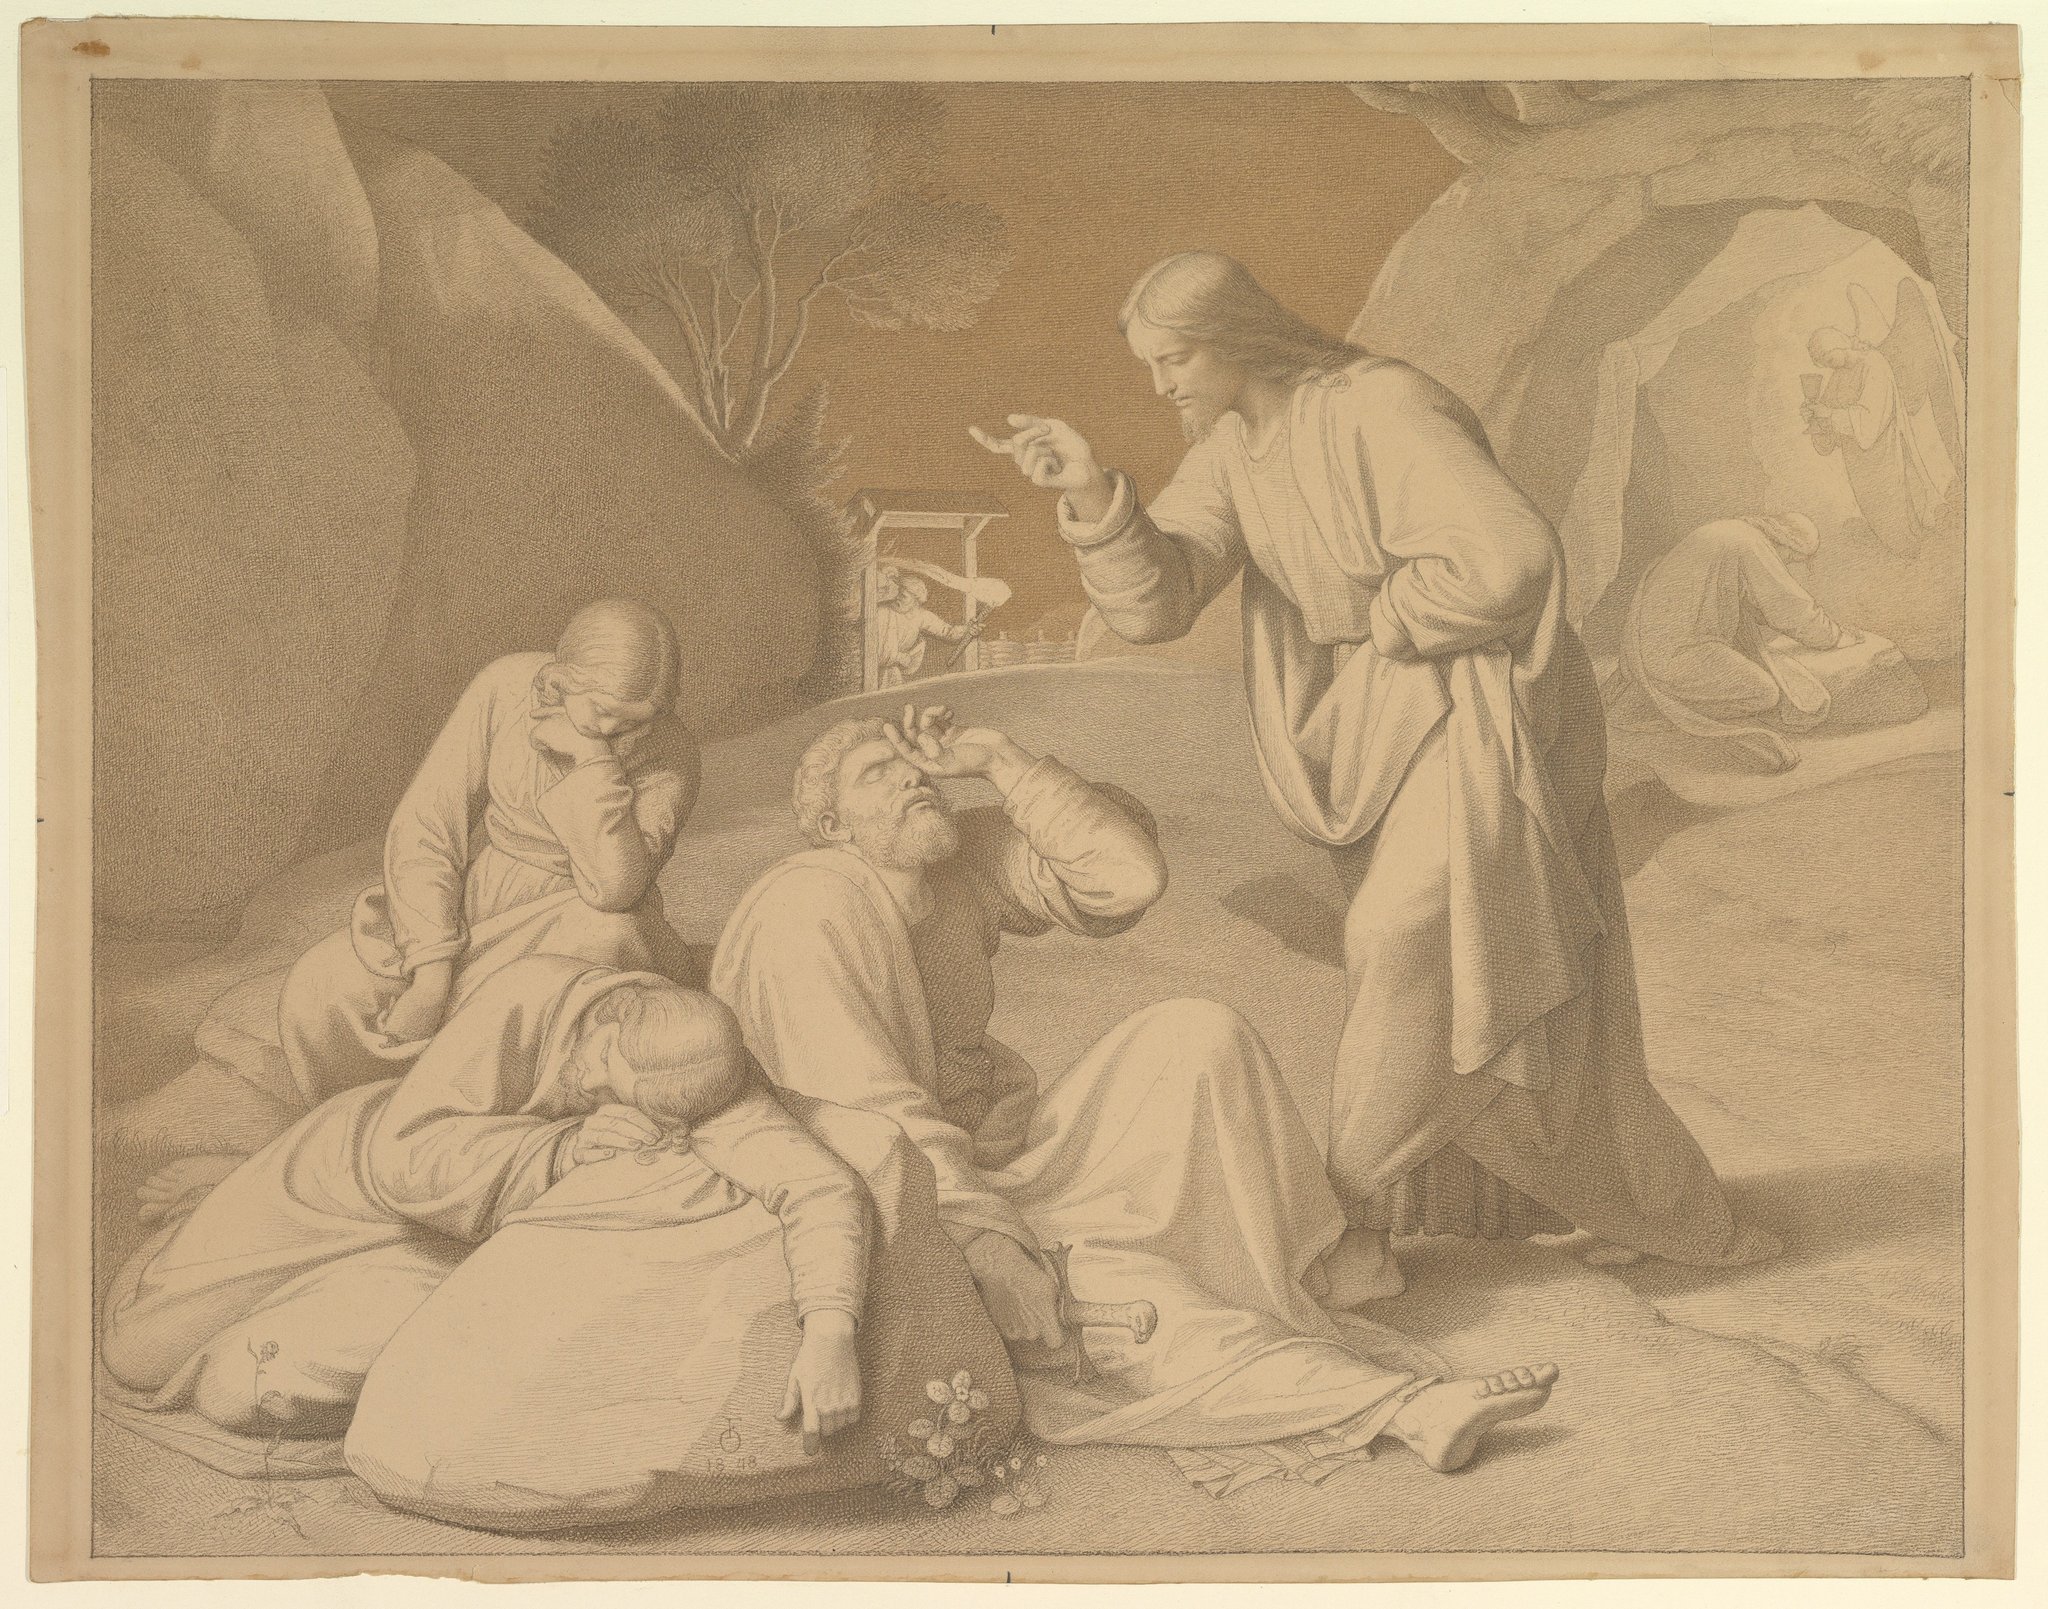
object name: drawing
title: Christ in the Garden of Gethsemane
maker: johann friedrich overbeck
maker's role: artist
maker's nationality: german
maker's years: 1789-1869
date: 1848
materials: crayon, watercolor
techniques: wash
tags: gardens,men,women,christ